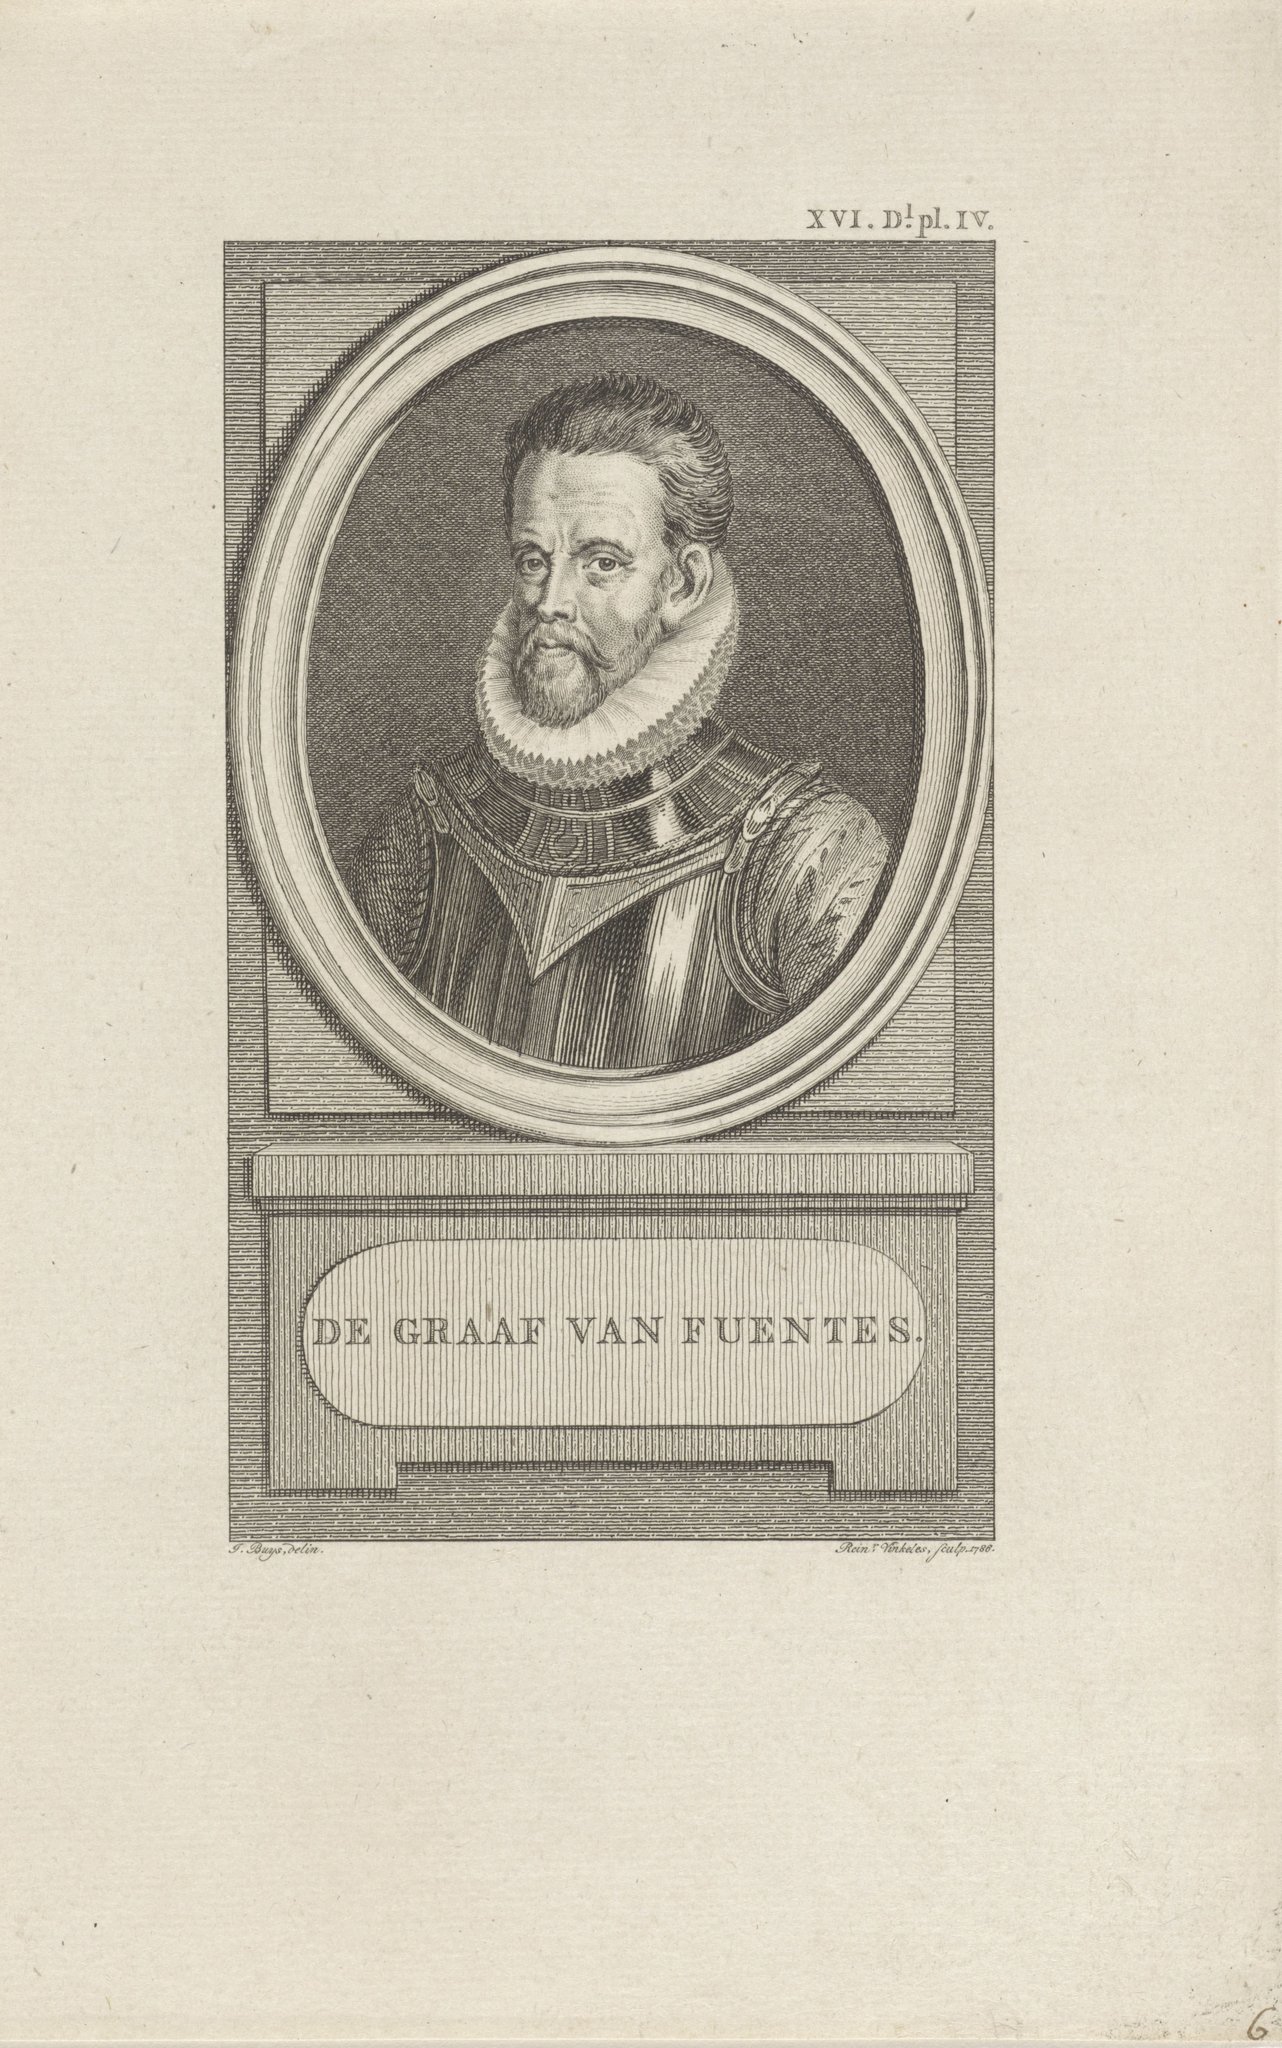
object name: book illustration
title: Portret van Pedro Enríquez de Toledo de Acevedo, graaf van Fuentes de Valdepero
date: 1788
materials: paper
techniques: engraving, etching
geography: amsterdam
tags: politician, pedro enríquez de acevedo (count of fuentes)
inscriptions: collector's mark: Lugt 2228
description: Prent gebruikt als boekillustratie in: Kok, Jacobus. Vaderlandsch woordenboek : met kaarten, plaaten en pourtraitten. Amsterdam: Johannes Allart, 1785-1796. Deel XVI.